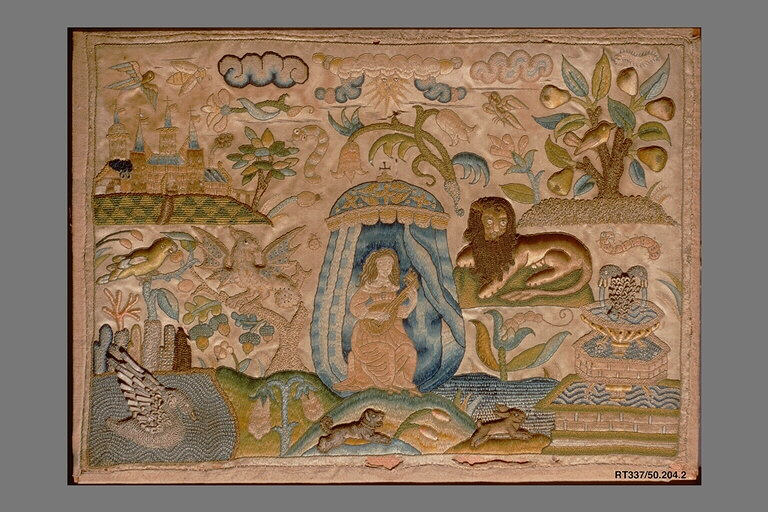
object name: embroidered picture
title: Lady with Lute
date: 1651-1675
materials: metal thread, silk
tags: birds,women,lutes,dogs,lions,rabbits,flowers